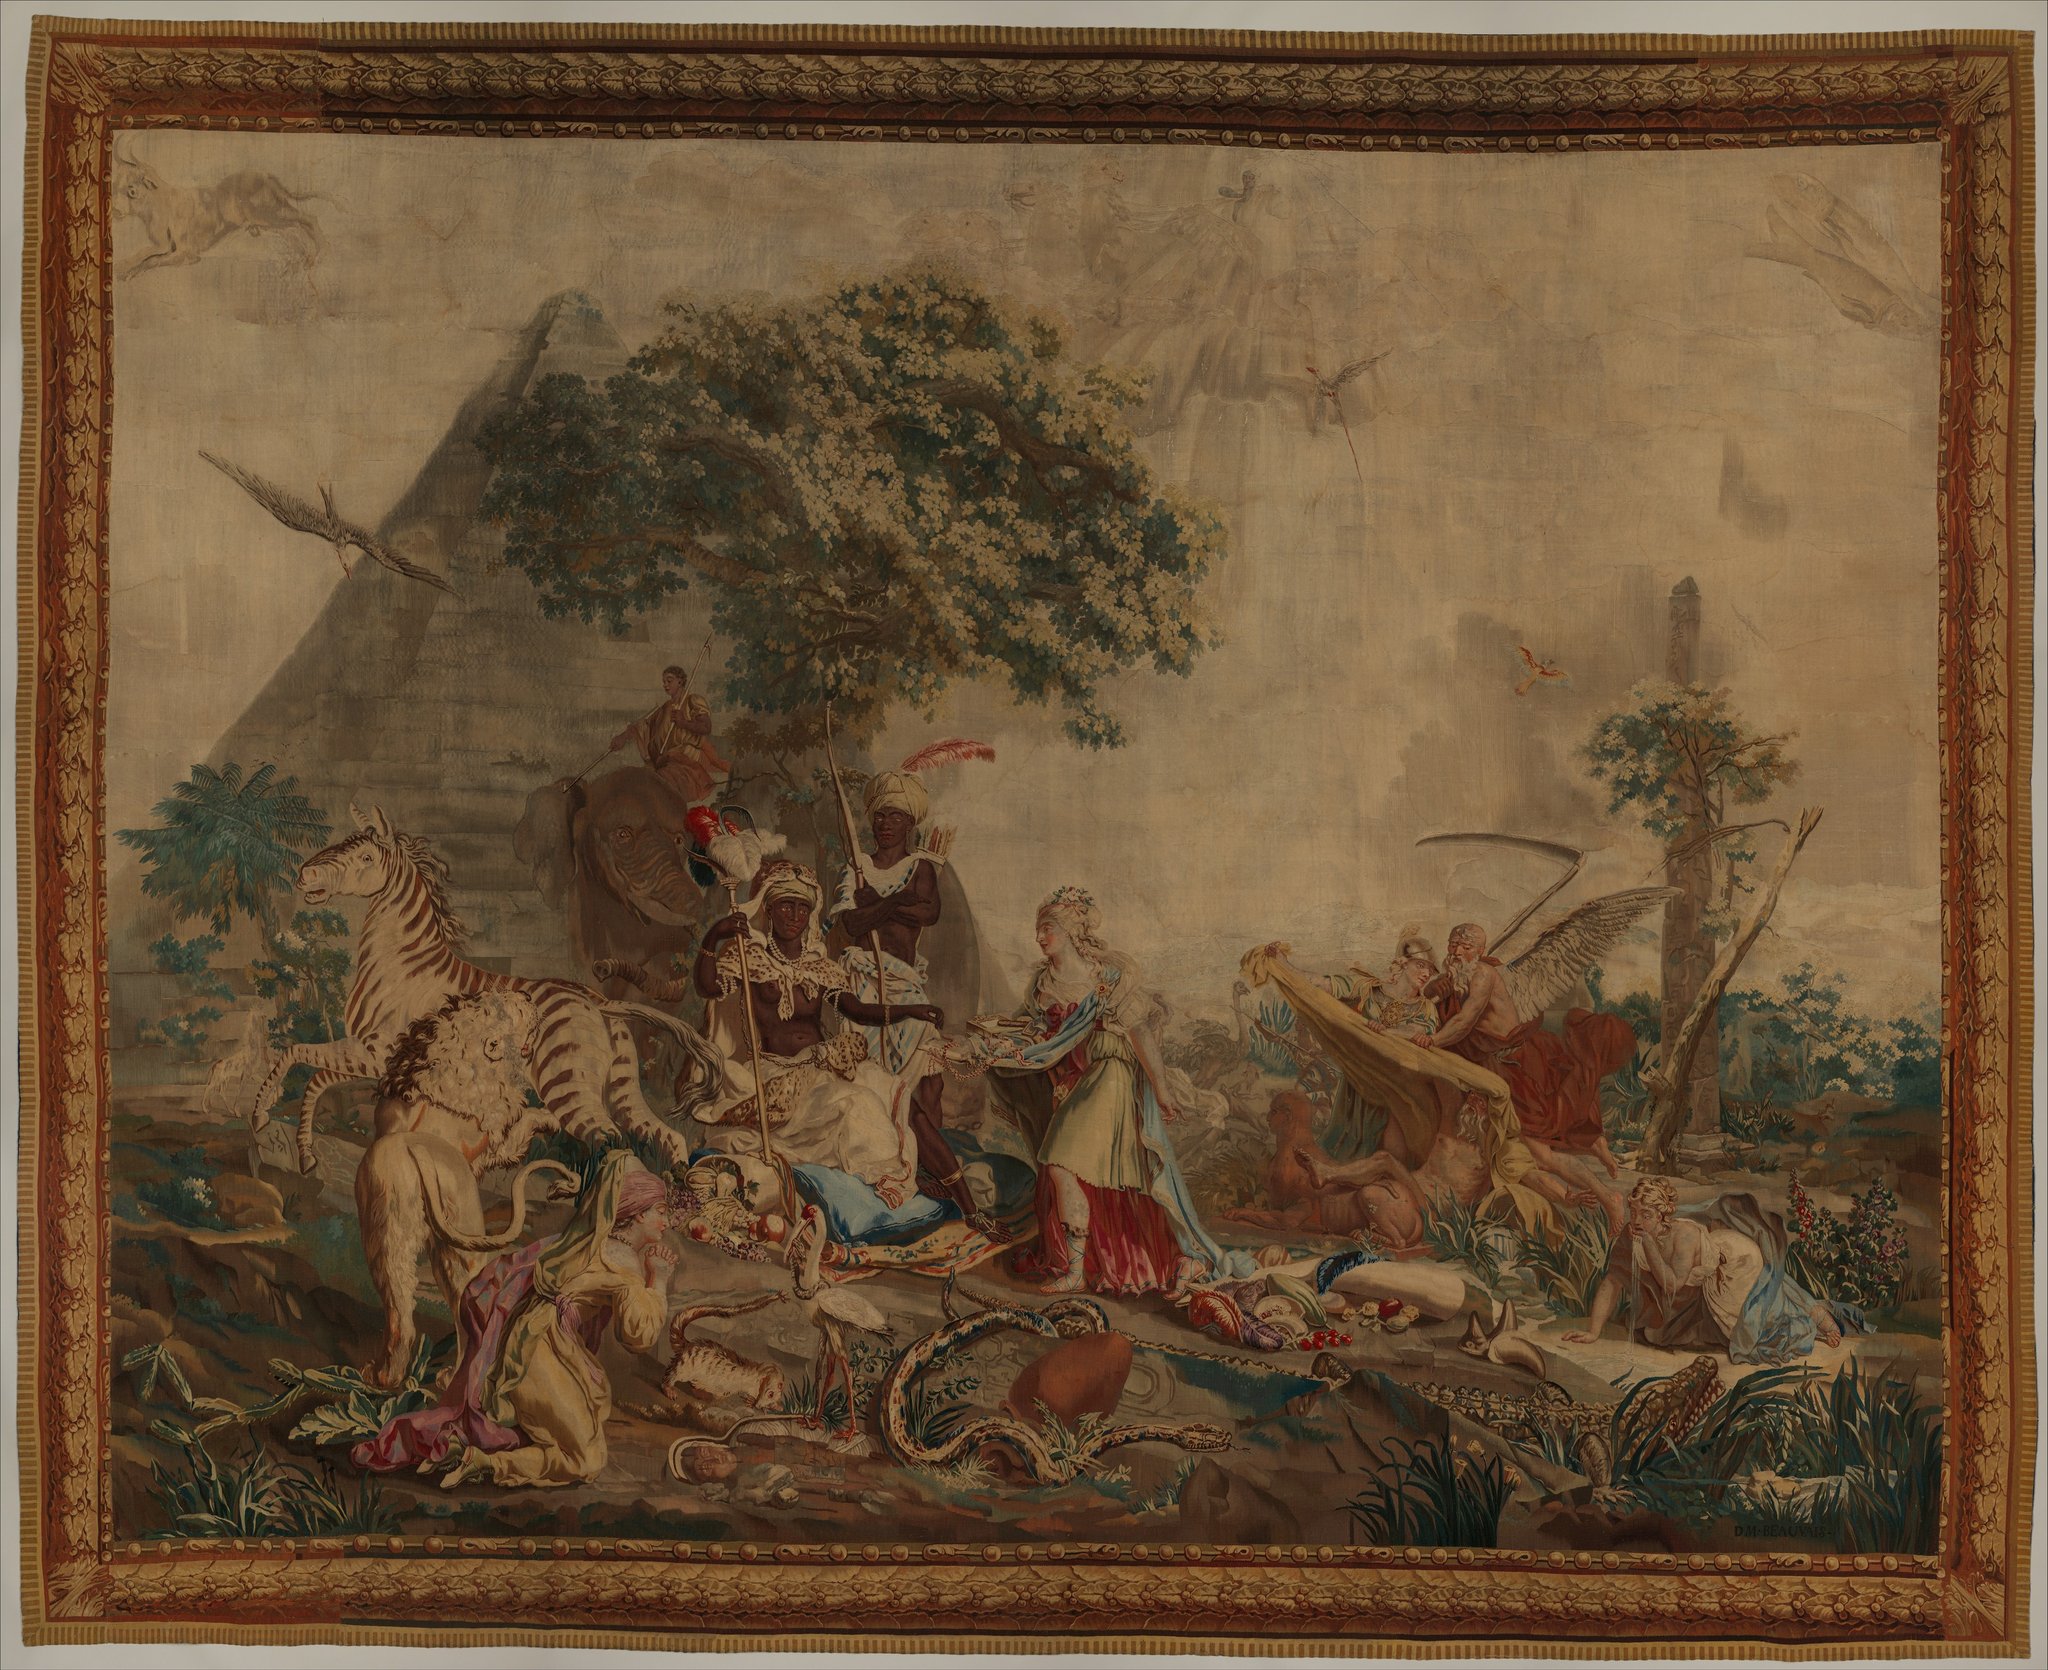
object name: tapestry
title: Africa from a set of The Four Continents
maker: jean jacques françois le barbier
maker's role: designer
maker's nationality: french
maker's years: 1738-1826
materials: silk, wool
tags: birds,pyramids,crocodiles,elephants,lions,snakes,zebras